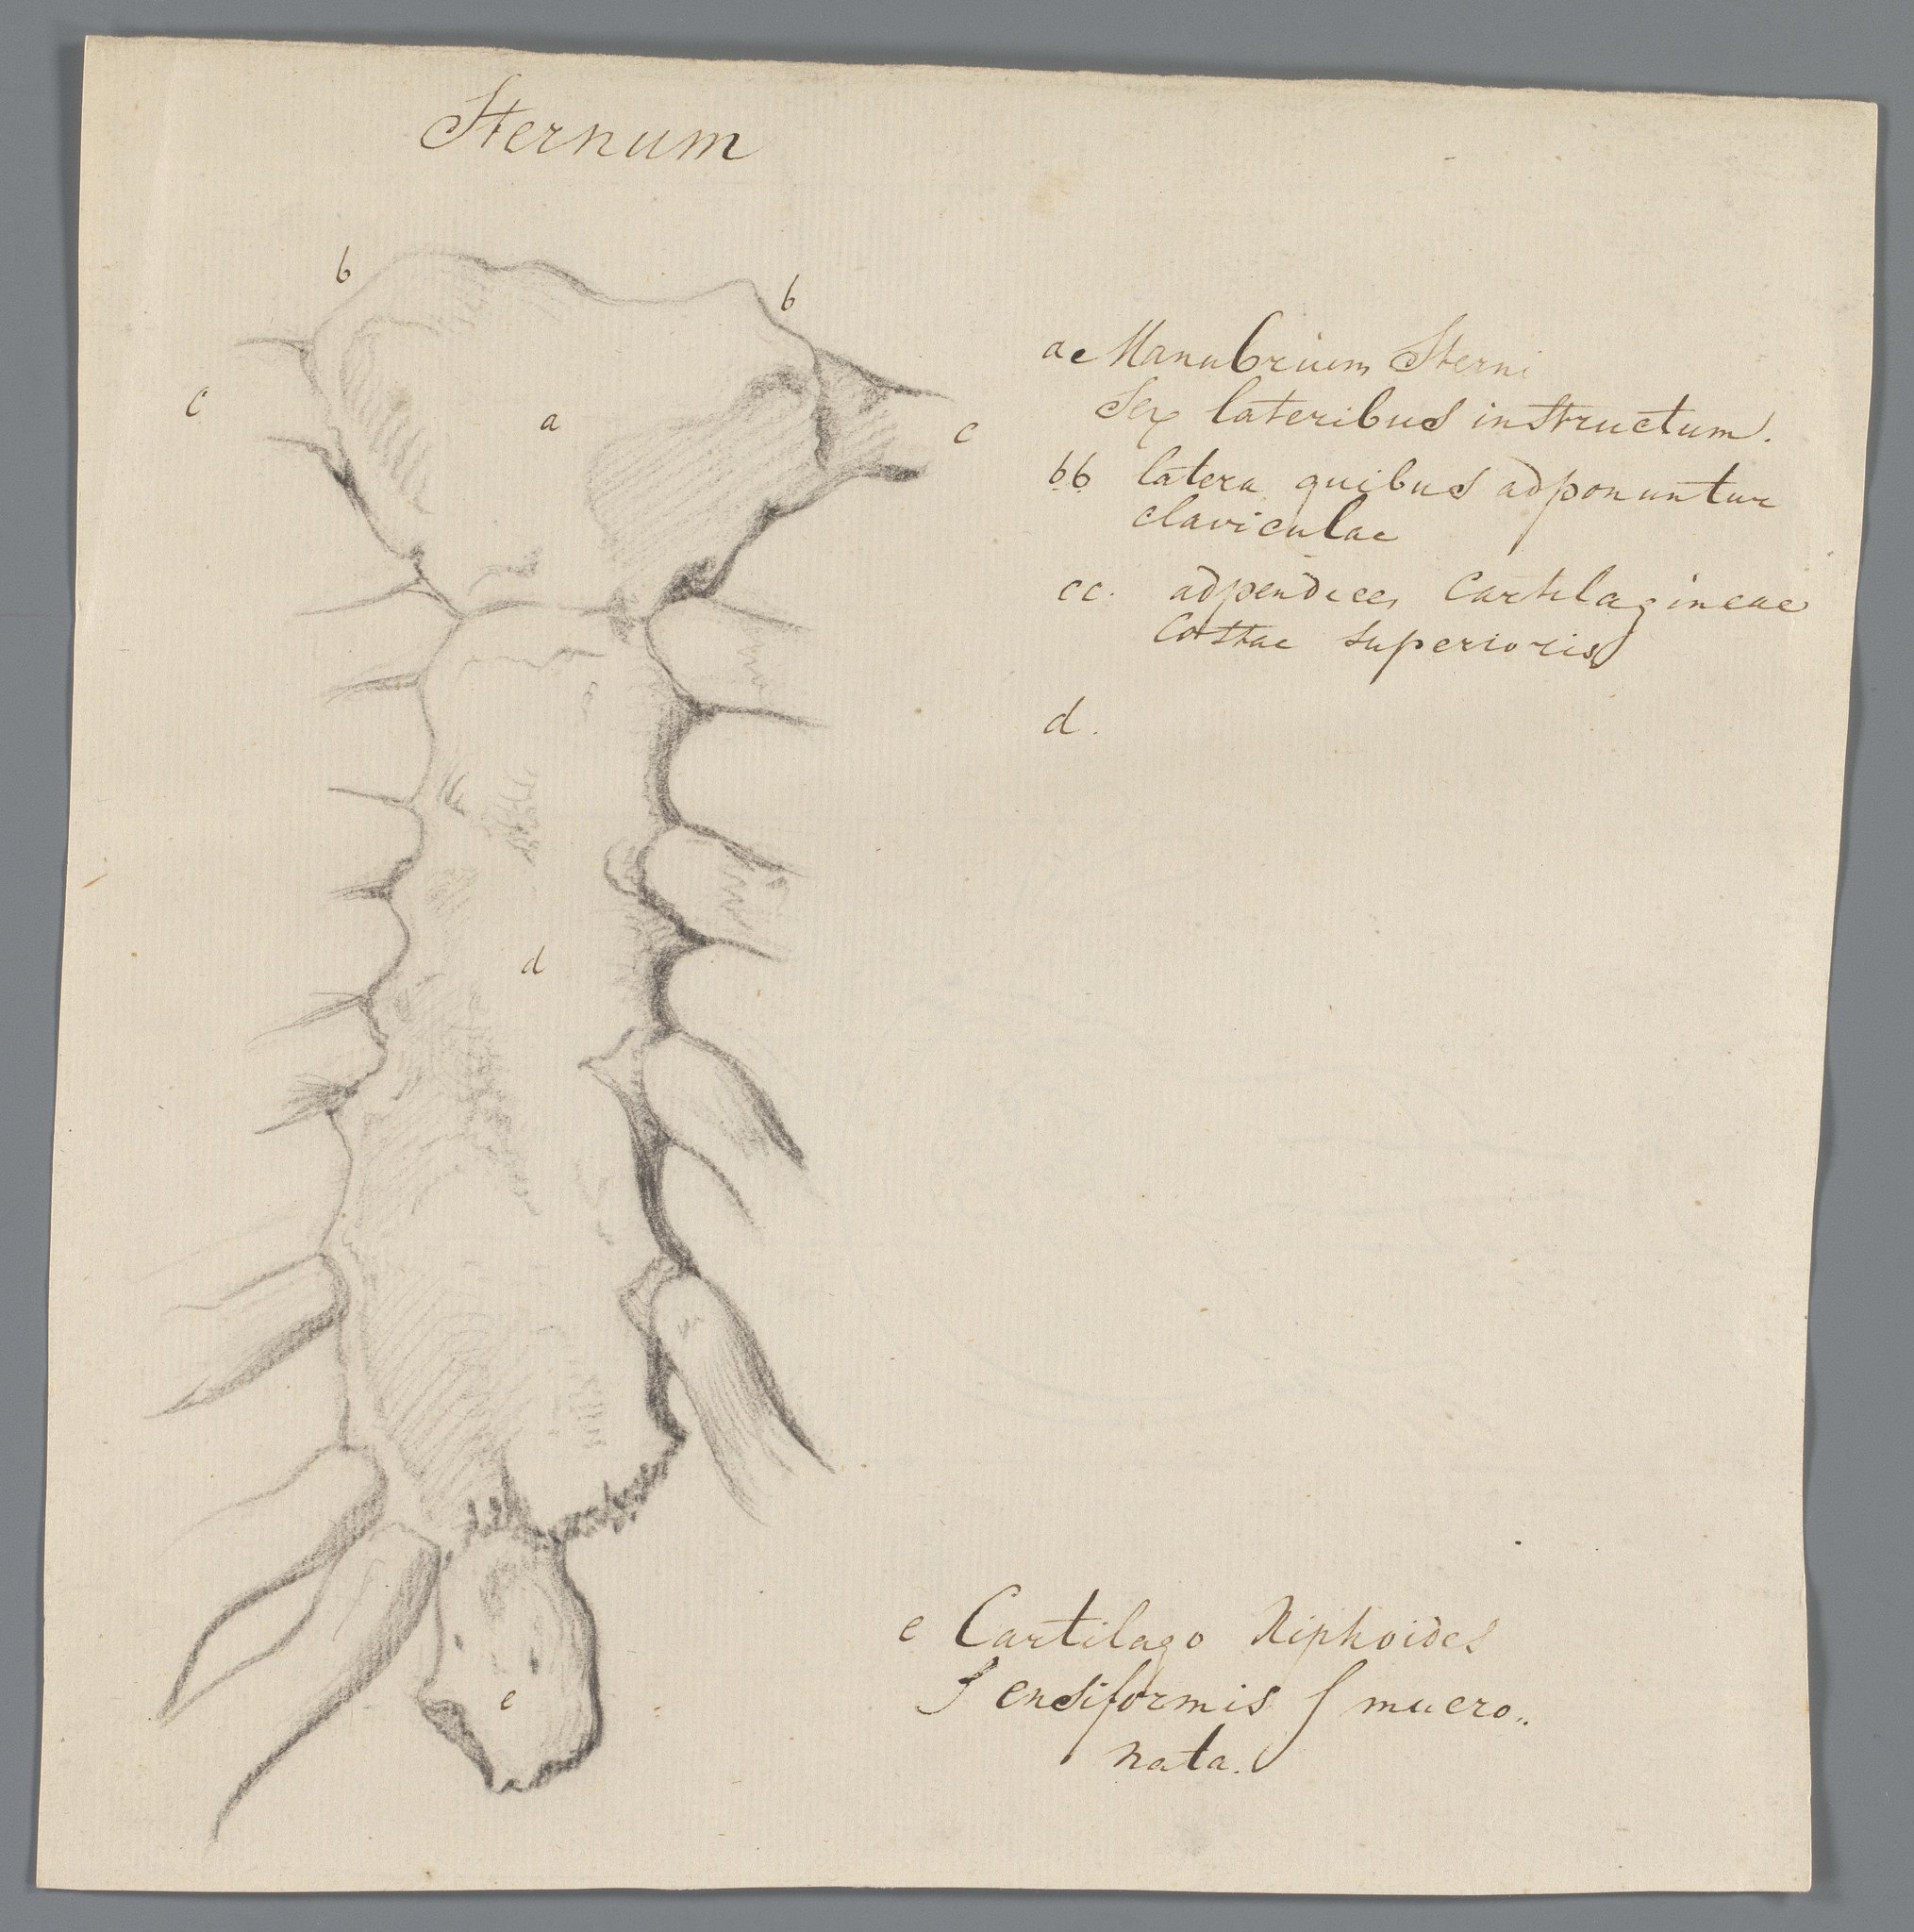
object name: drawing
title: Het borstbeen (Sternum)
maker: gerard allebé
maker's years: 1849-1879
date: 1818-1900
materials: chalk, paper